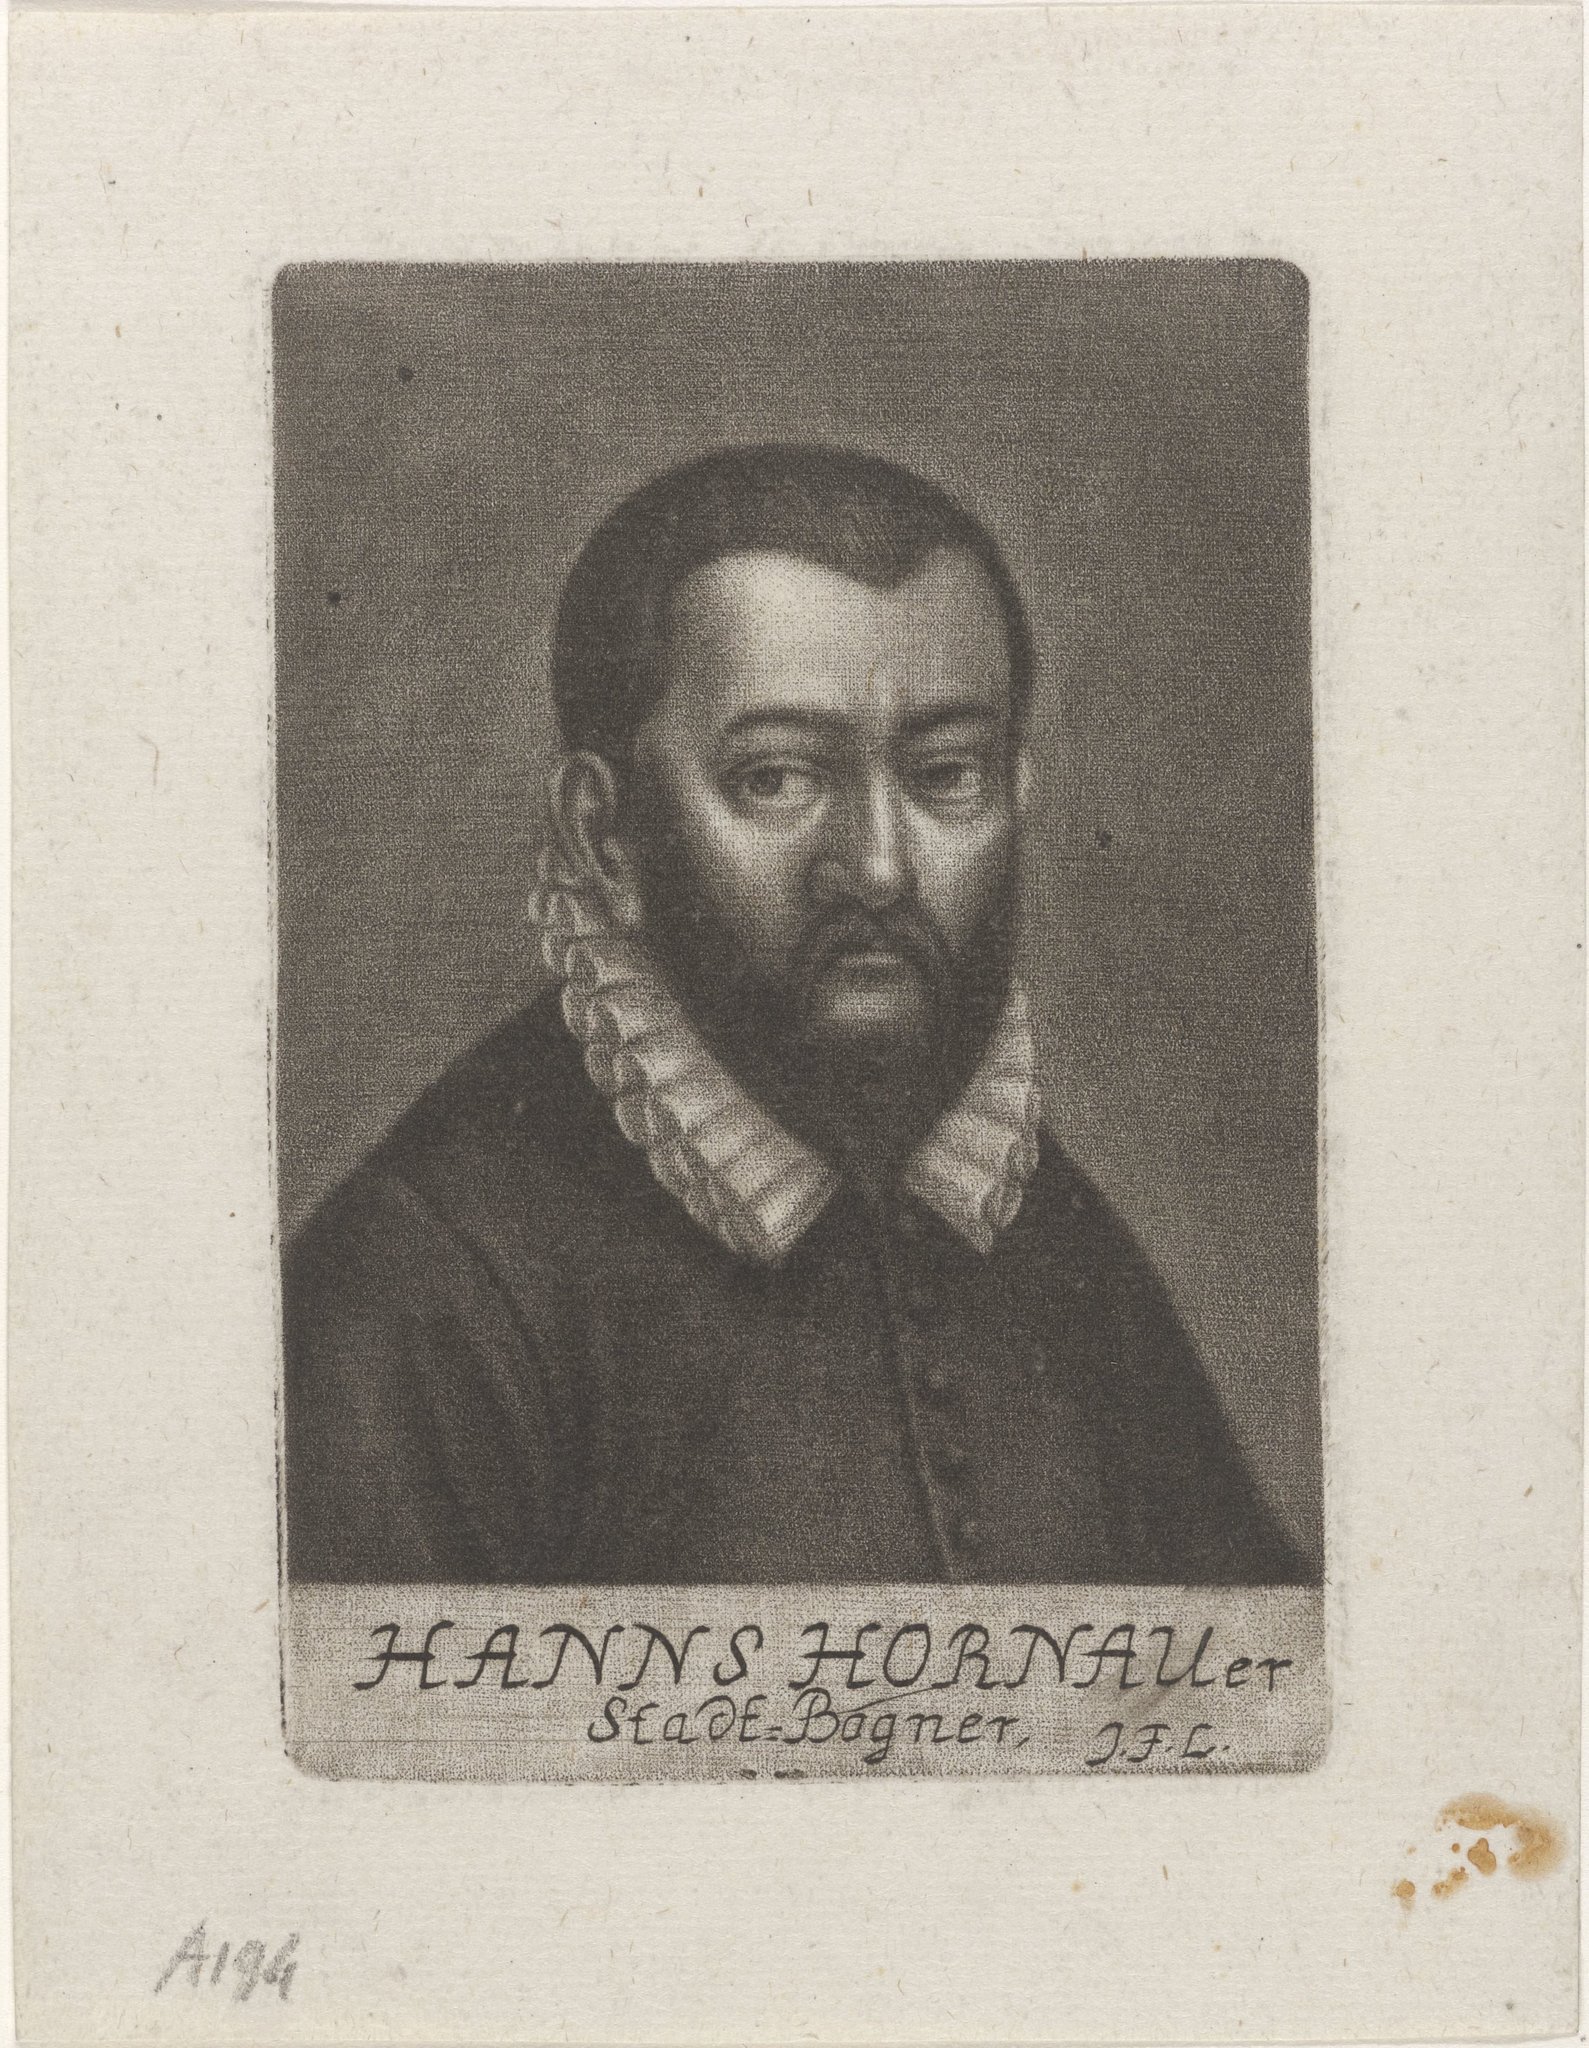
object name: print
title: Portret van Hans Hornauer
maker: johann friedrich leonard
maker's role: print maker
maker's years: 1633-1680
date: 1643-1680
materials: paper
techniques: engraving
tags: hans hornauer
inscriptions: collector's mark: Lugt 2228